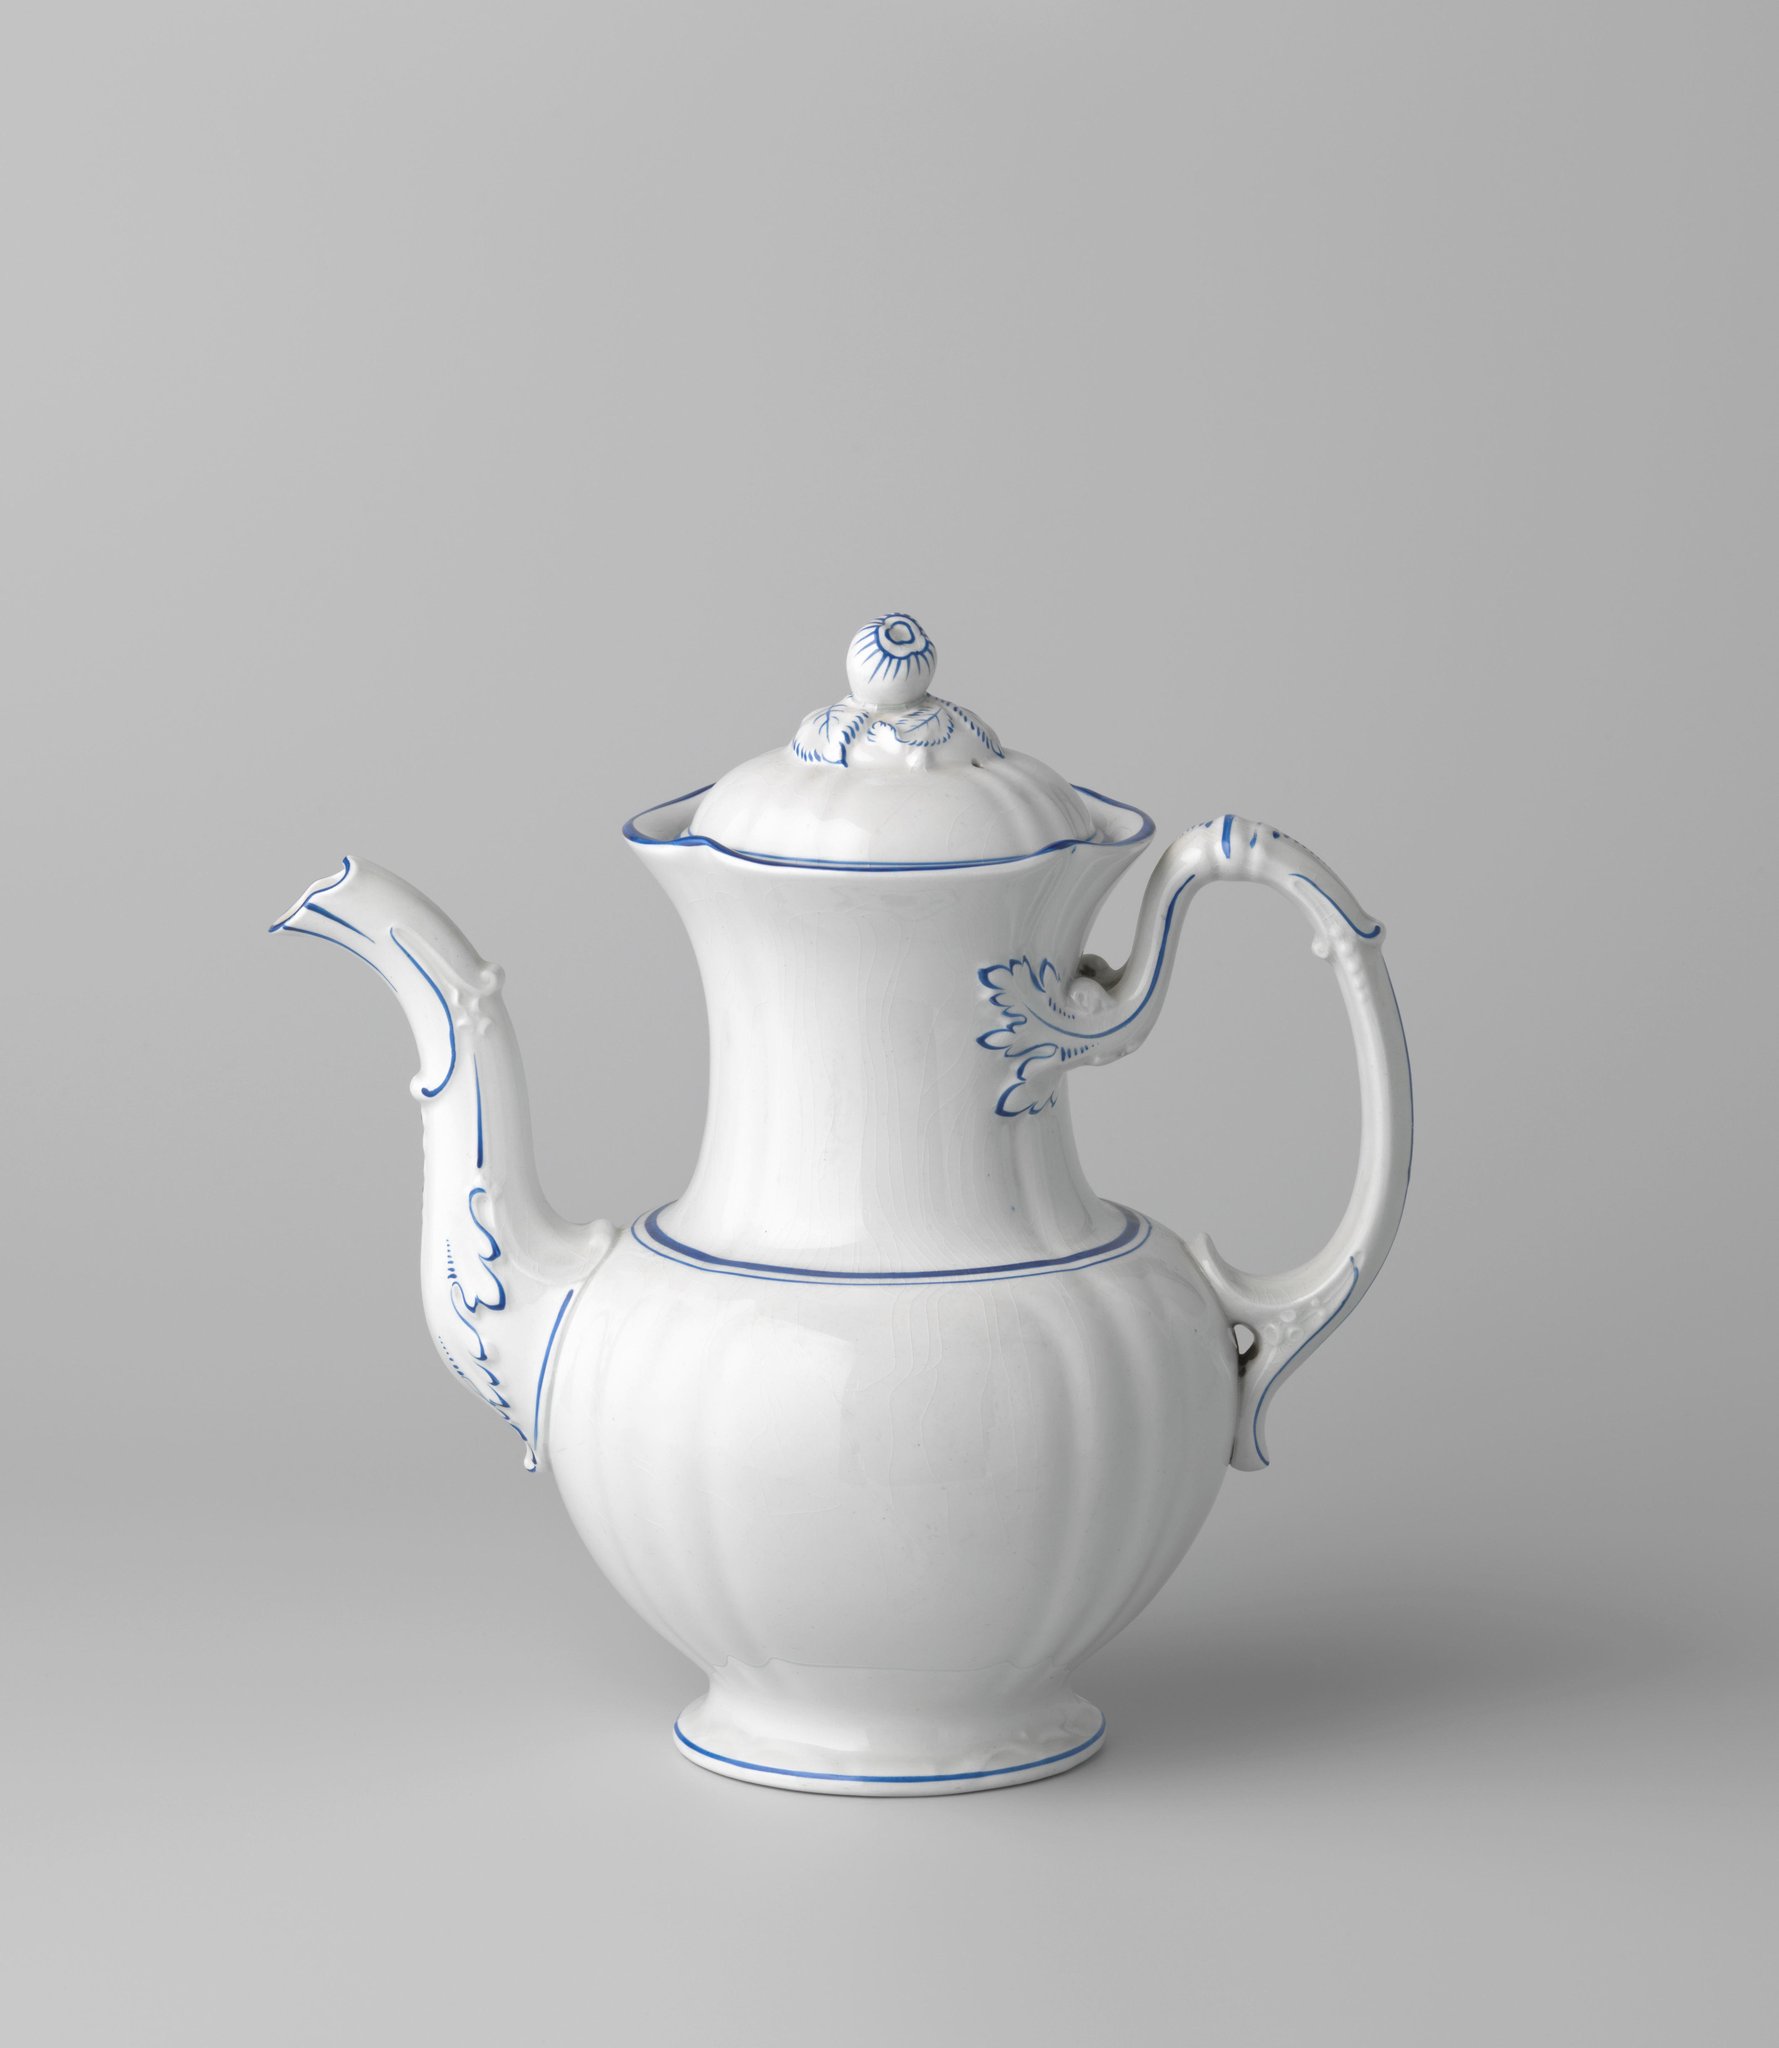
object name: lid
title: Deksel, wit, met blauwe biezen en peervormige dekselknop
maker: petrus regout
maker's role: plateelbakker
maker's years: 1801-1879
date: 1860-1890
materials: creamware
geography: maastricht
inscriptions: check stamp: ‘P. REGOUT // MAASTRICHT // 16 X’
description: Deksel van aardewerk, behorend bij een koffie- en theeservies, wit, met blauwe biezen en peervormige dekselknop.